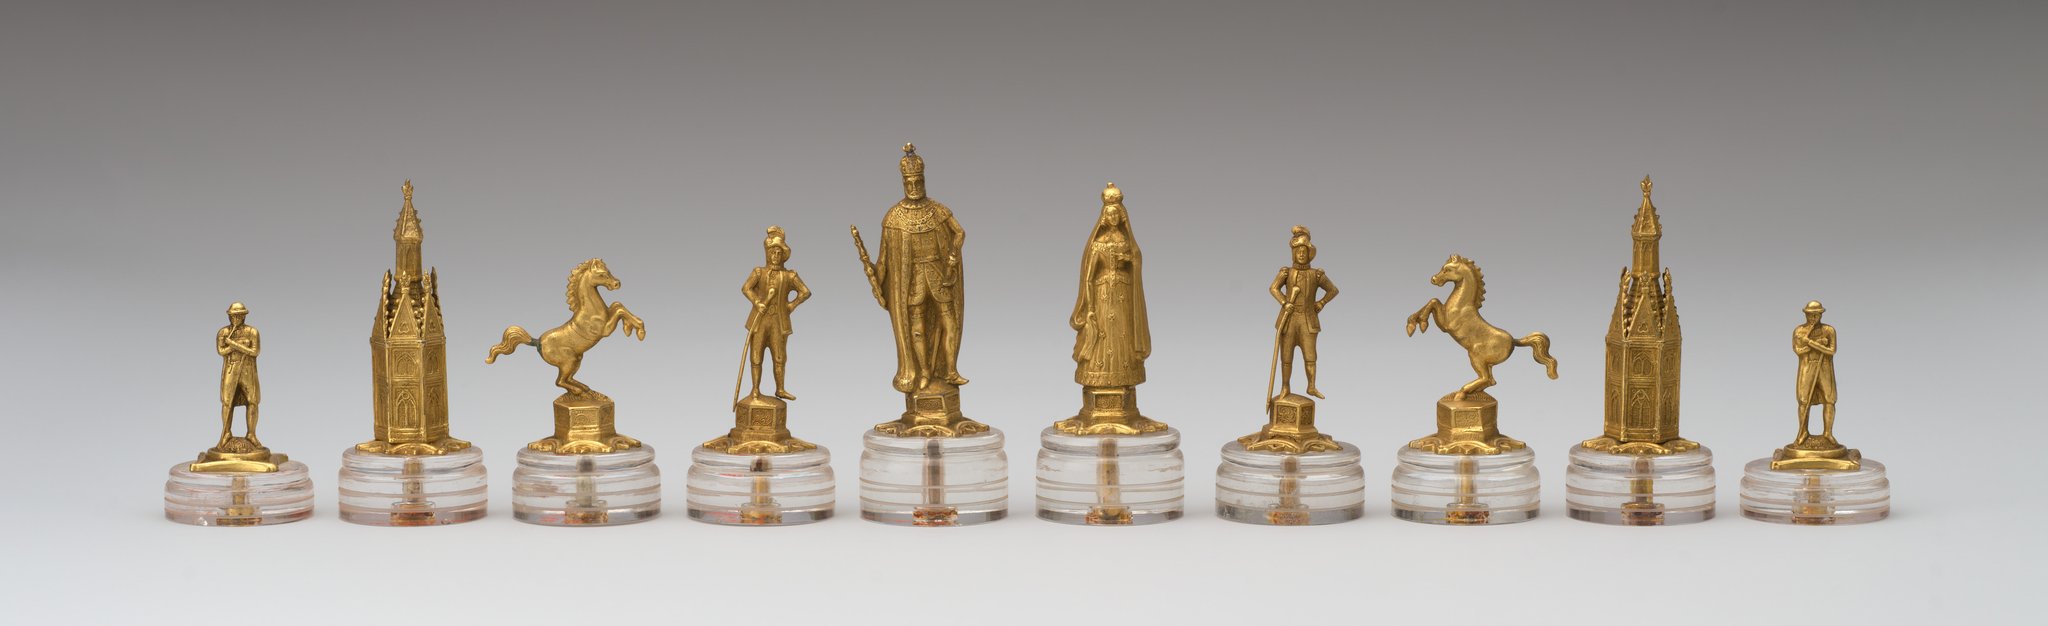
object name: chessman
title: Gothic revival figures chessmen (32)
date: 1801-1900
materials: quartz, silver, silver gilt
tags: chess,games